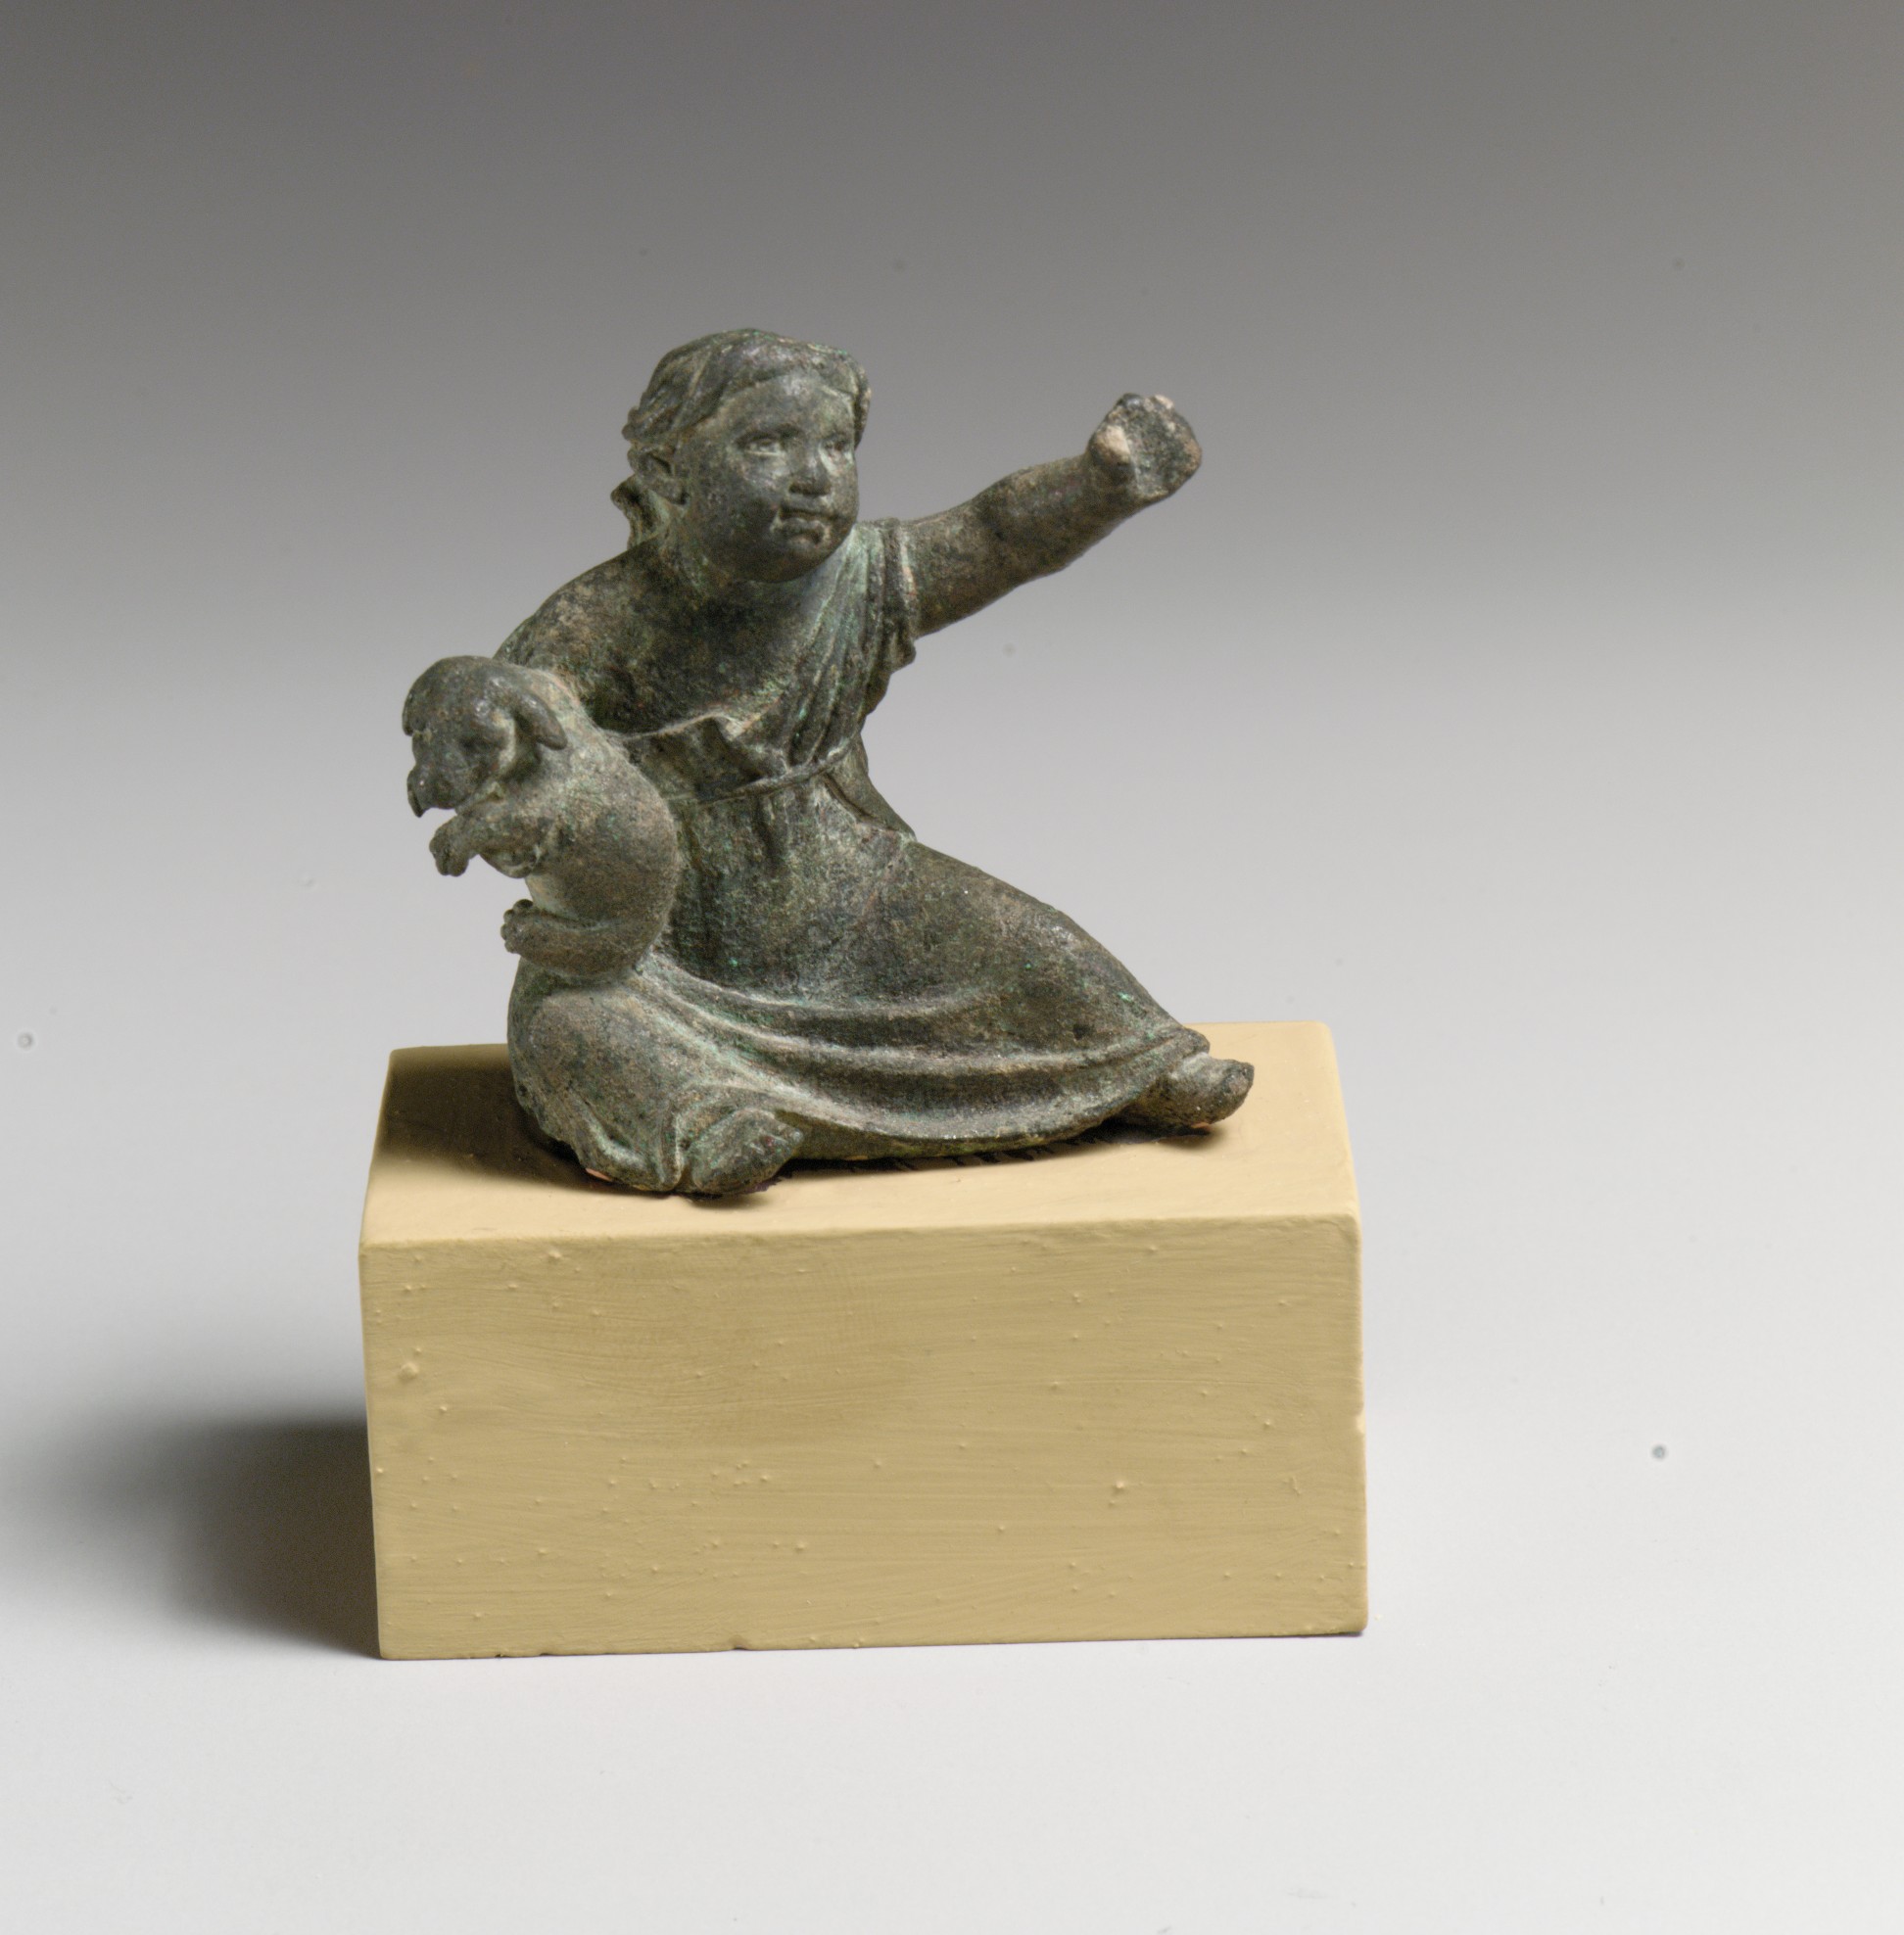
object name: statuette of a girl holding a dog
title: Bronze statuette of a girl holding a dog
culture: greek or roman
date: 100 BCE-200 CE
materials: bronze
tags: girls,dogs